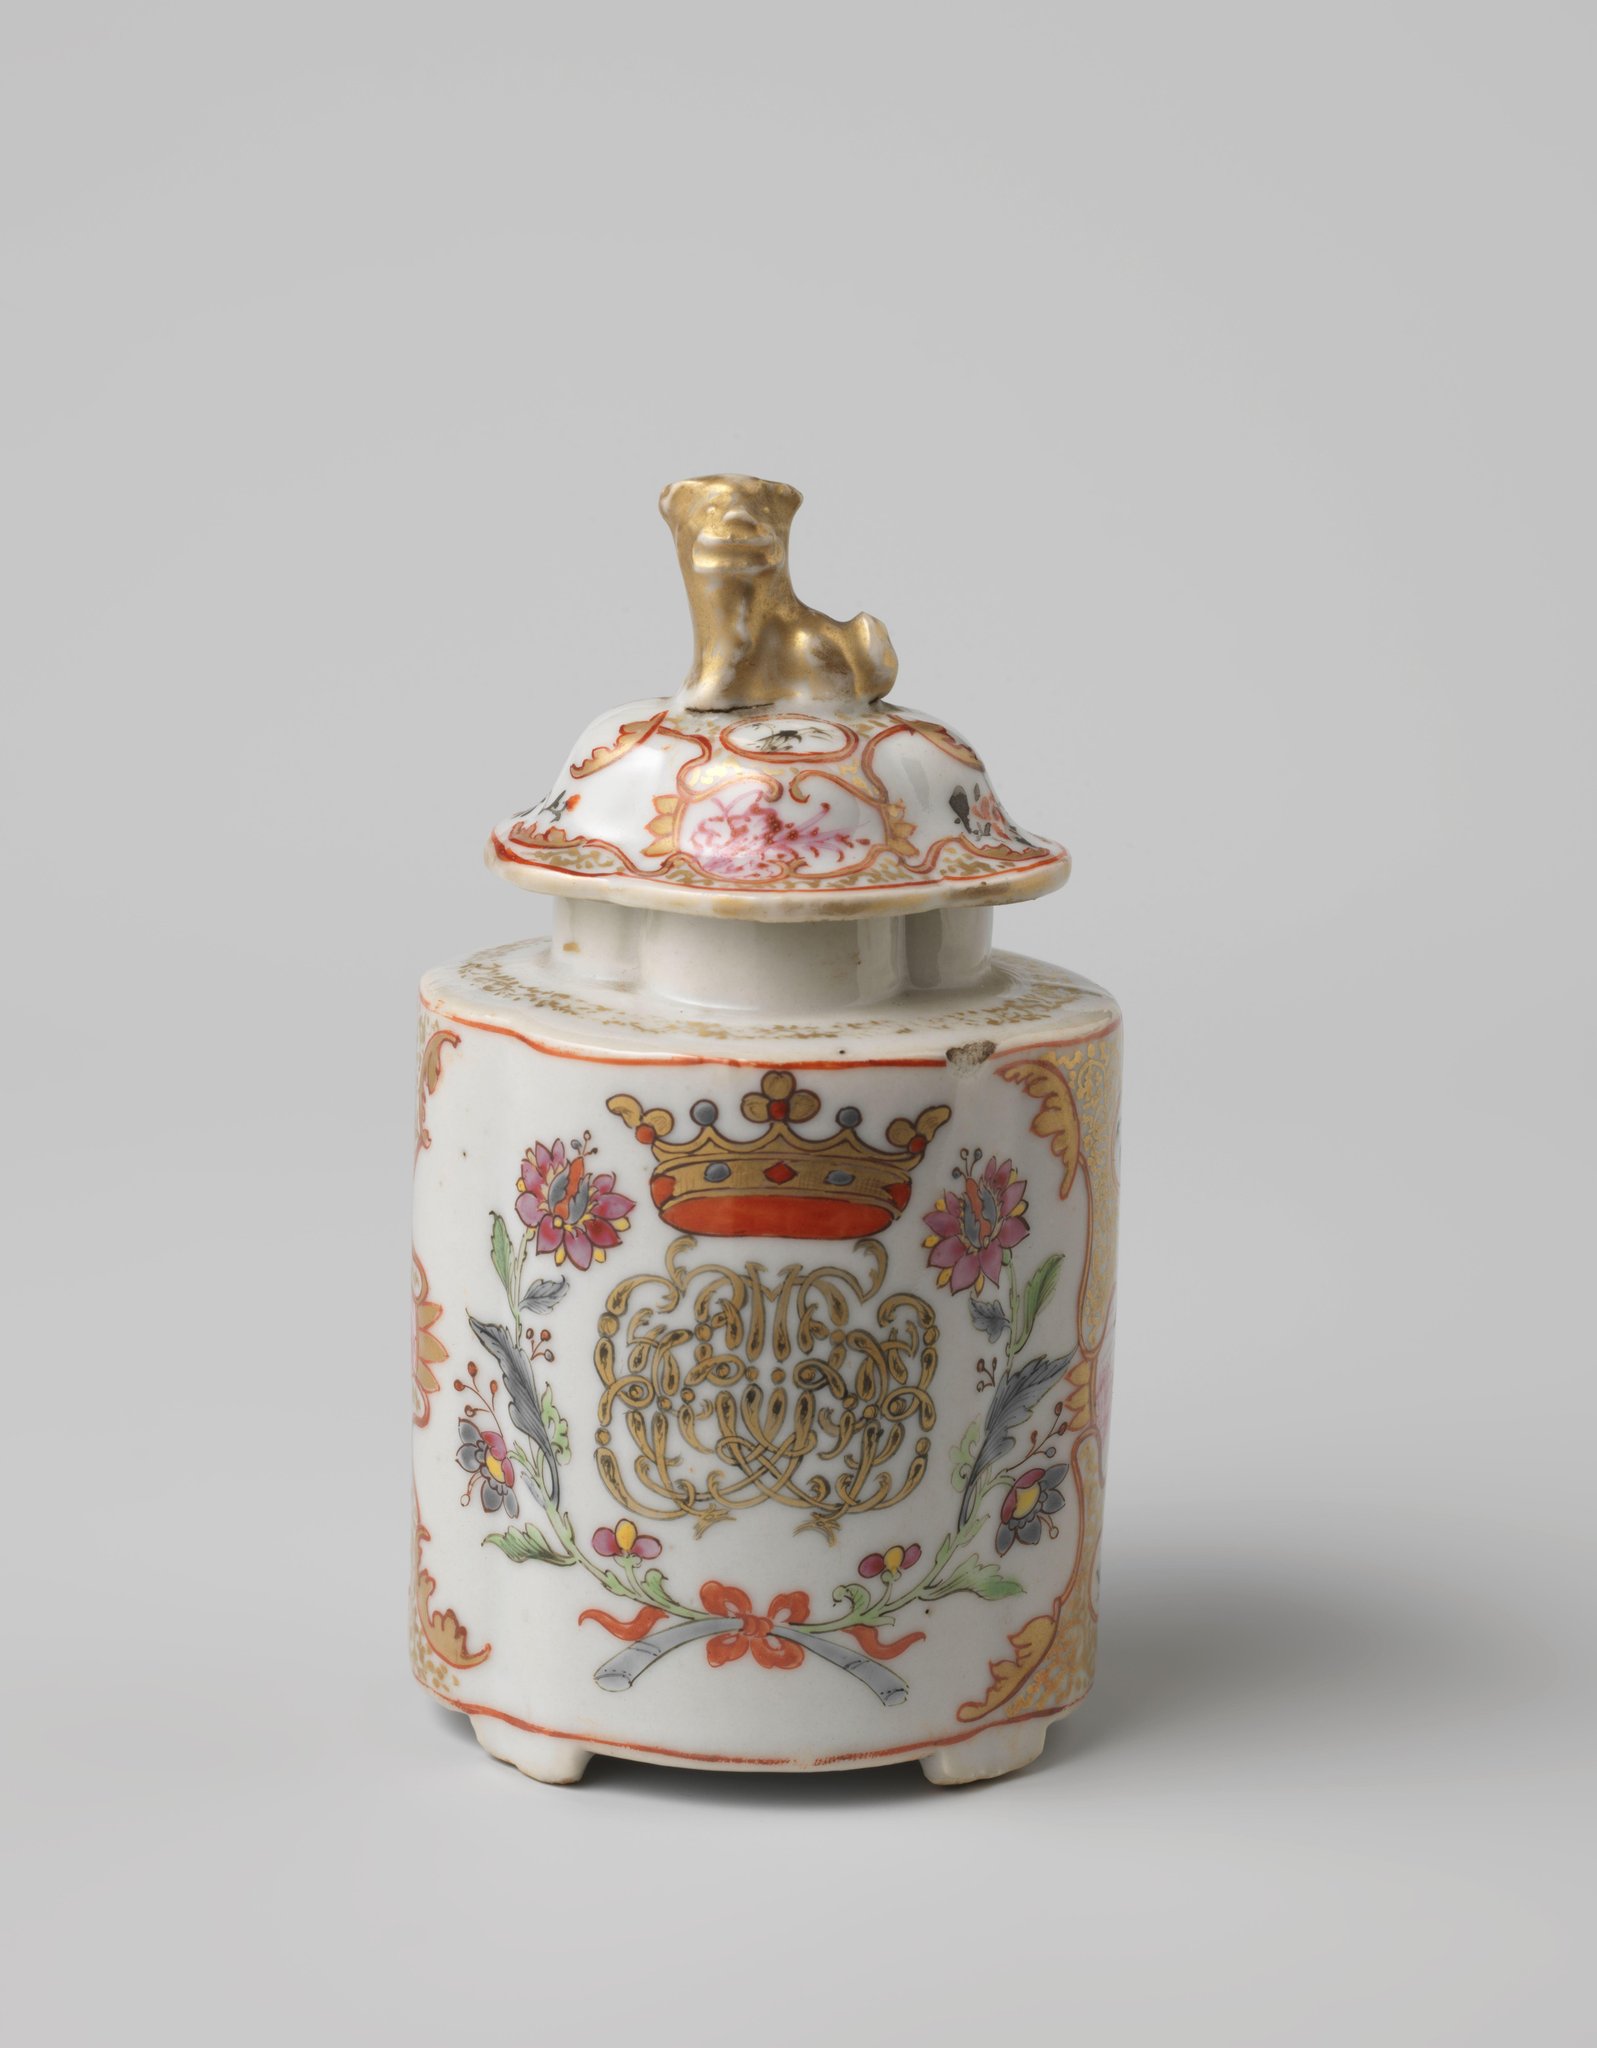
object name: lid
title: Tea caddy with a crowned, illegible monogram surrounded by two flower sprays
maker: Anonymous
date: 1750-1774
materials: glaze, gold, paint, porcelain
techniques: firing, forming, gilding, turning, vitrification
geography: china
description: Deksel van theebus van porselein met viermaal gelobde wand en rand en vier korte voeten, beschilderd op het glazuur in blauw, rood, roze, groen, geel, zwart en goud. De dekselknop in de vorm van een shishi (leeuwhond); op de deksel bloemranken en cartouches met landschappen of bloemtakken. Europese voorstelling in emailkleuren.